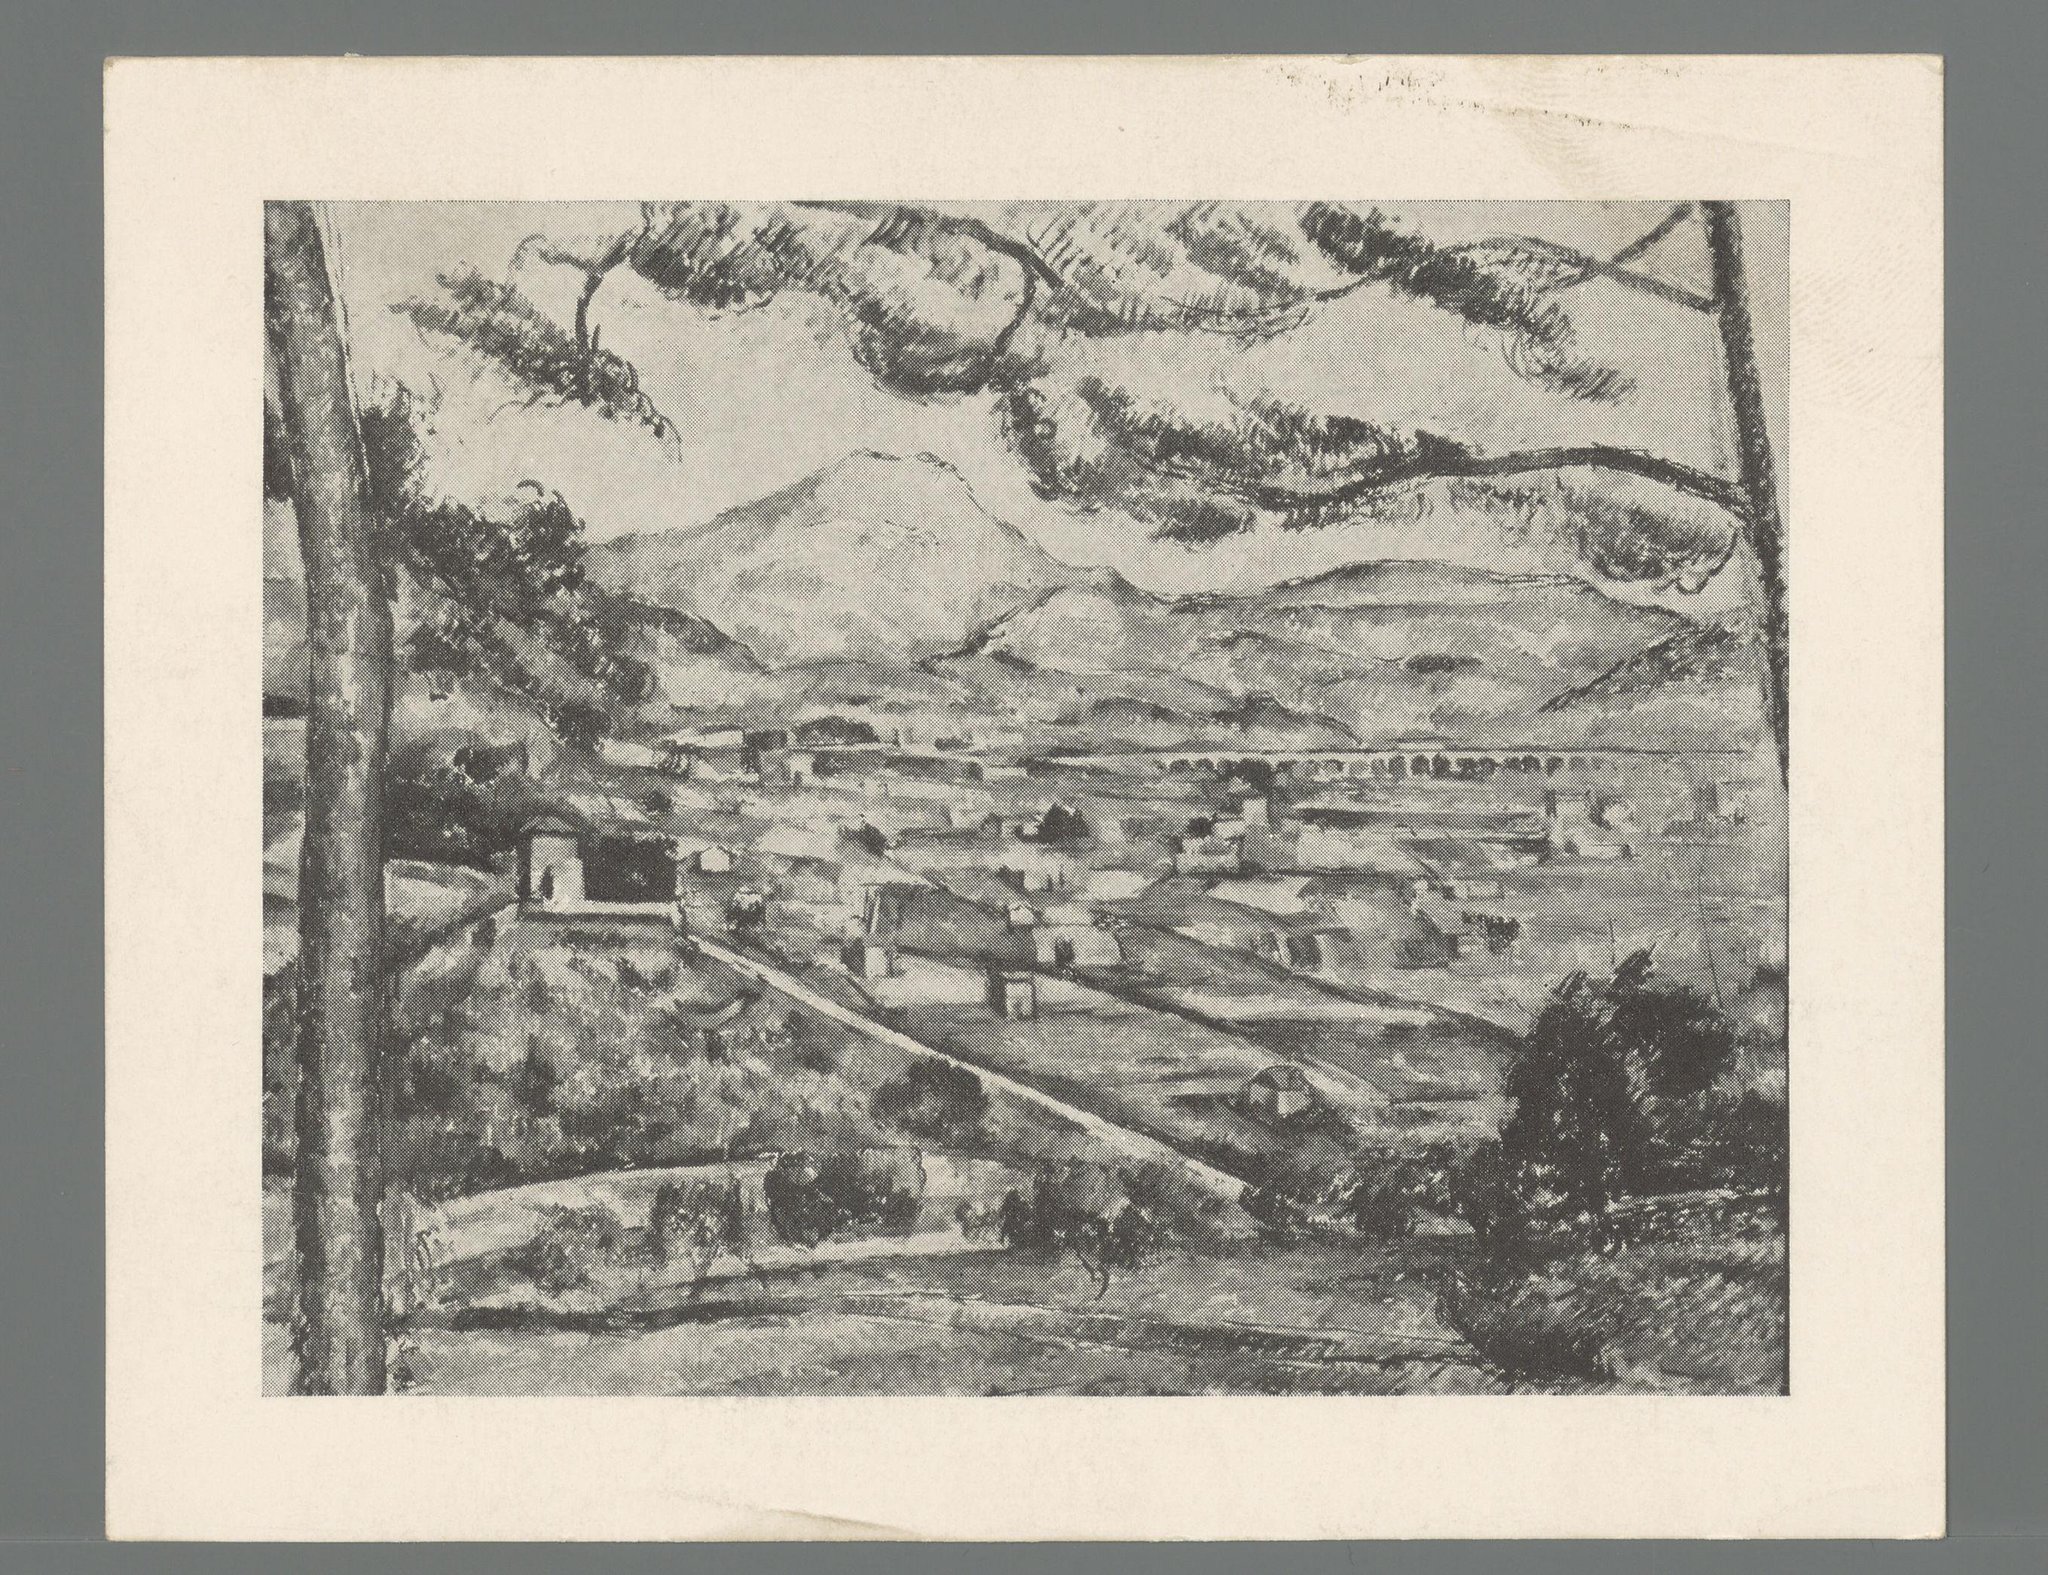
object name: photomechanical print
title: Mt. St. Victoire by Cézanne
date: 1925-1948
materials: cardboard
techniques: autotype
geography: washington d.c.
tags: prospect of village, silhouette of village, mountains